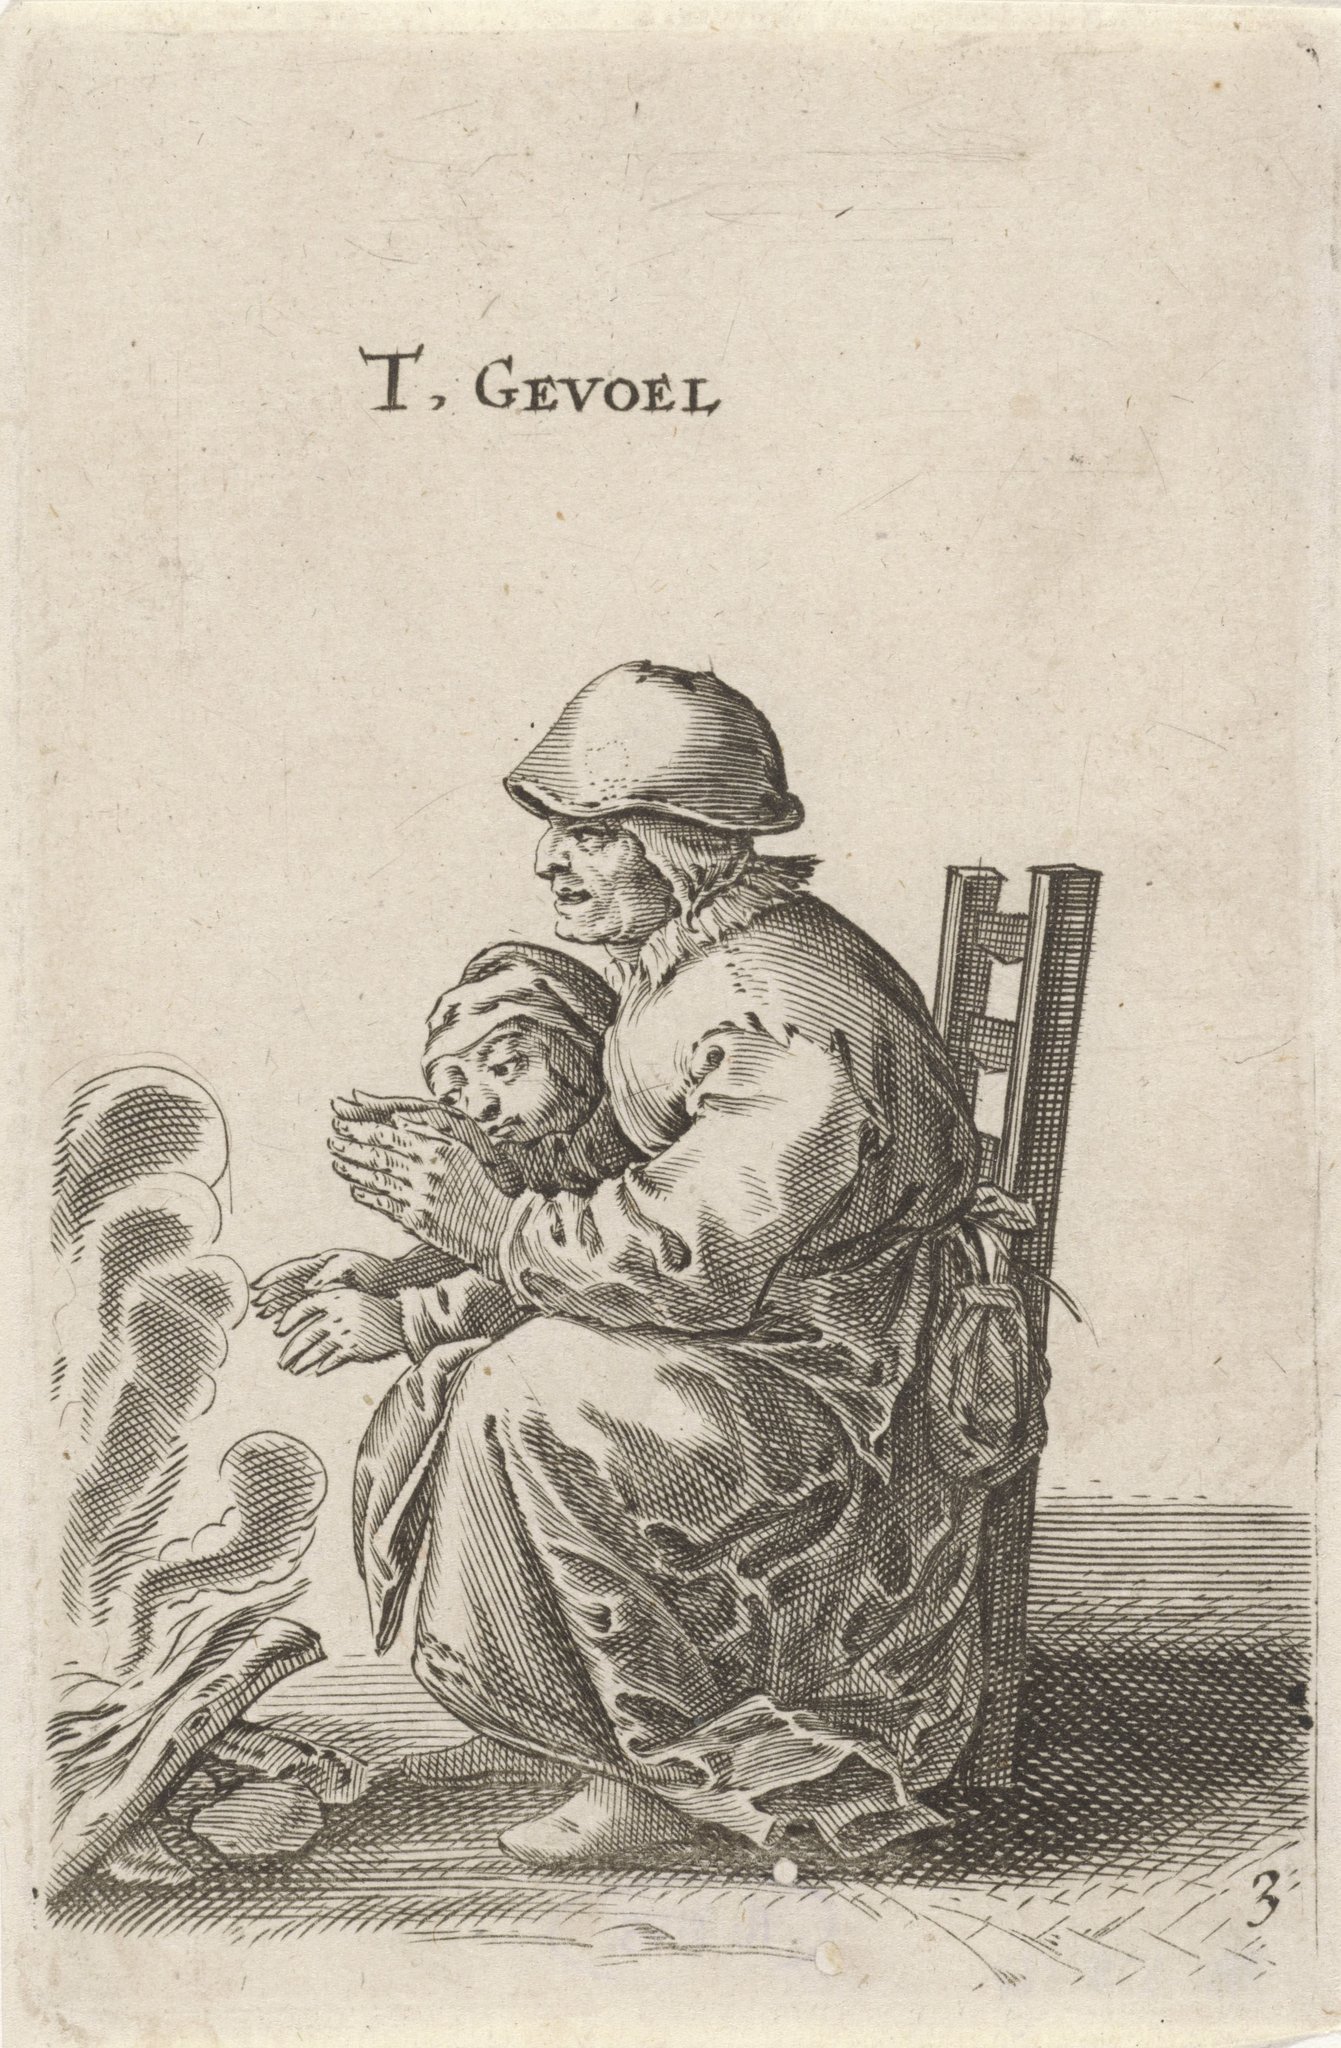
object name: print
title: T. Gevoel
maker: salomon savery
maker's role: print maker, publisher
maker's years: 1594-1683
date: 1638-1665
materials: paper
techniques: engraving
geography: amsterdam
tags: warming oneself at a fire (or hearth, stove, fire-pan, brazier), old woman, camp-fire; watch-fire, feeling (one of the five senses)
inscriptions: collector's mark: Lugt 2228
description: Een oude vrouw en een kind warmen gezamenlijk hun handen bij een vuur. De prent maakt deel uit van een zesdelige serie prenten met voorstellingen van de vijf zintuigen (ongenummerde titelprent).